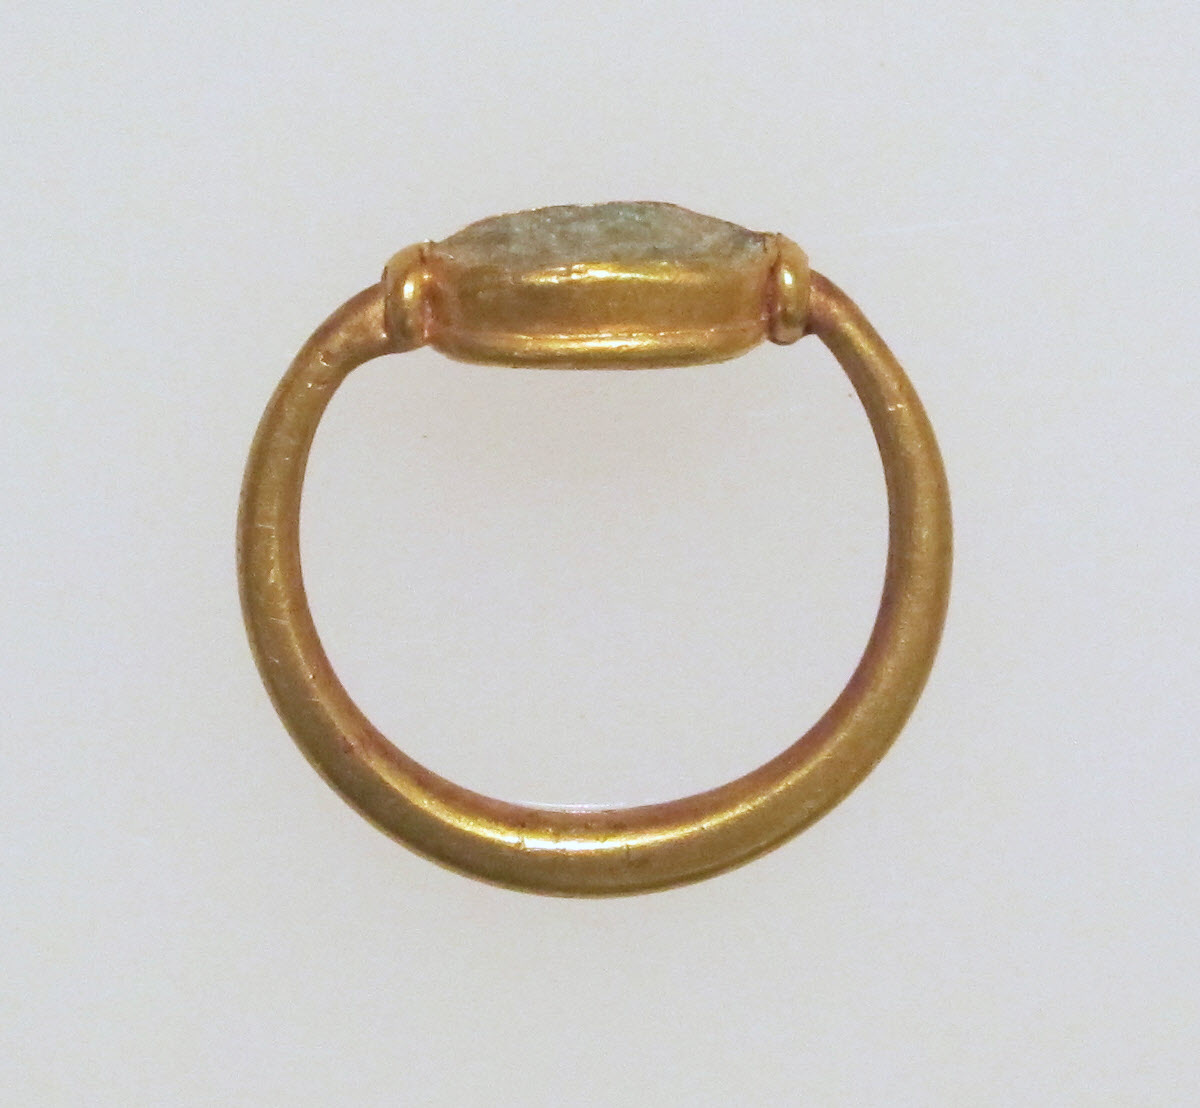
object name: ring with glass paste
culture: roman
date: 100 BCE-300 CE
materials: glass, gold, paste